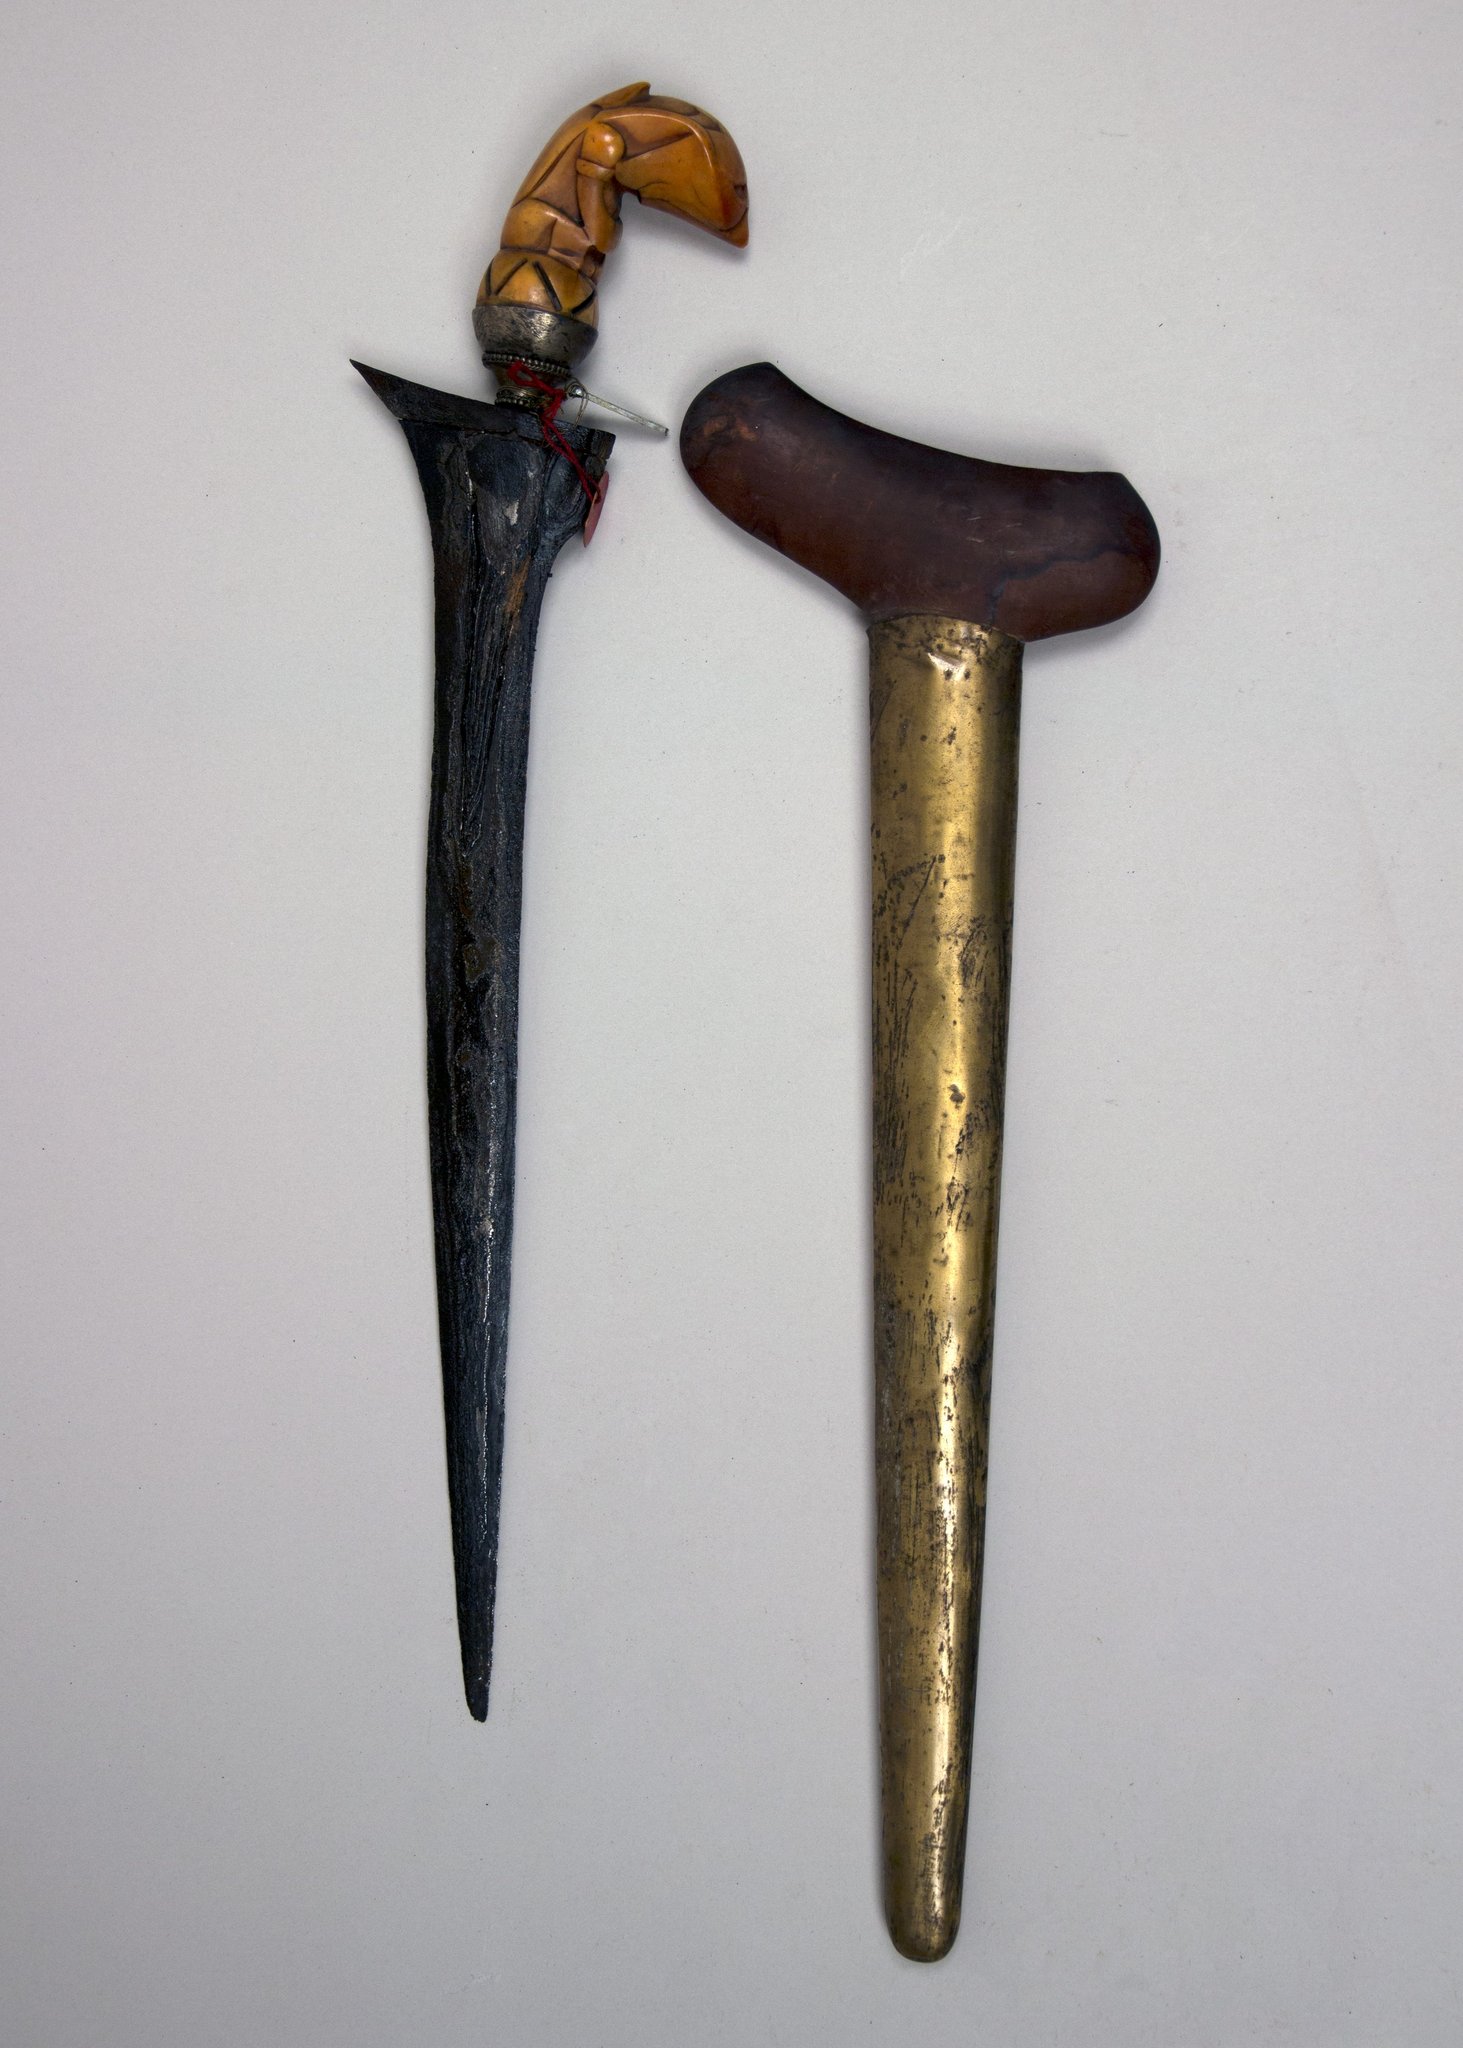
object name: kris with sheath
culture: javanese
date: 1501-1900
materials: ivory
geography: indonesia